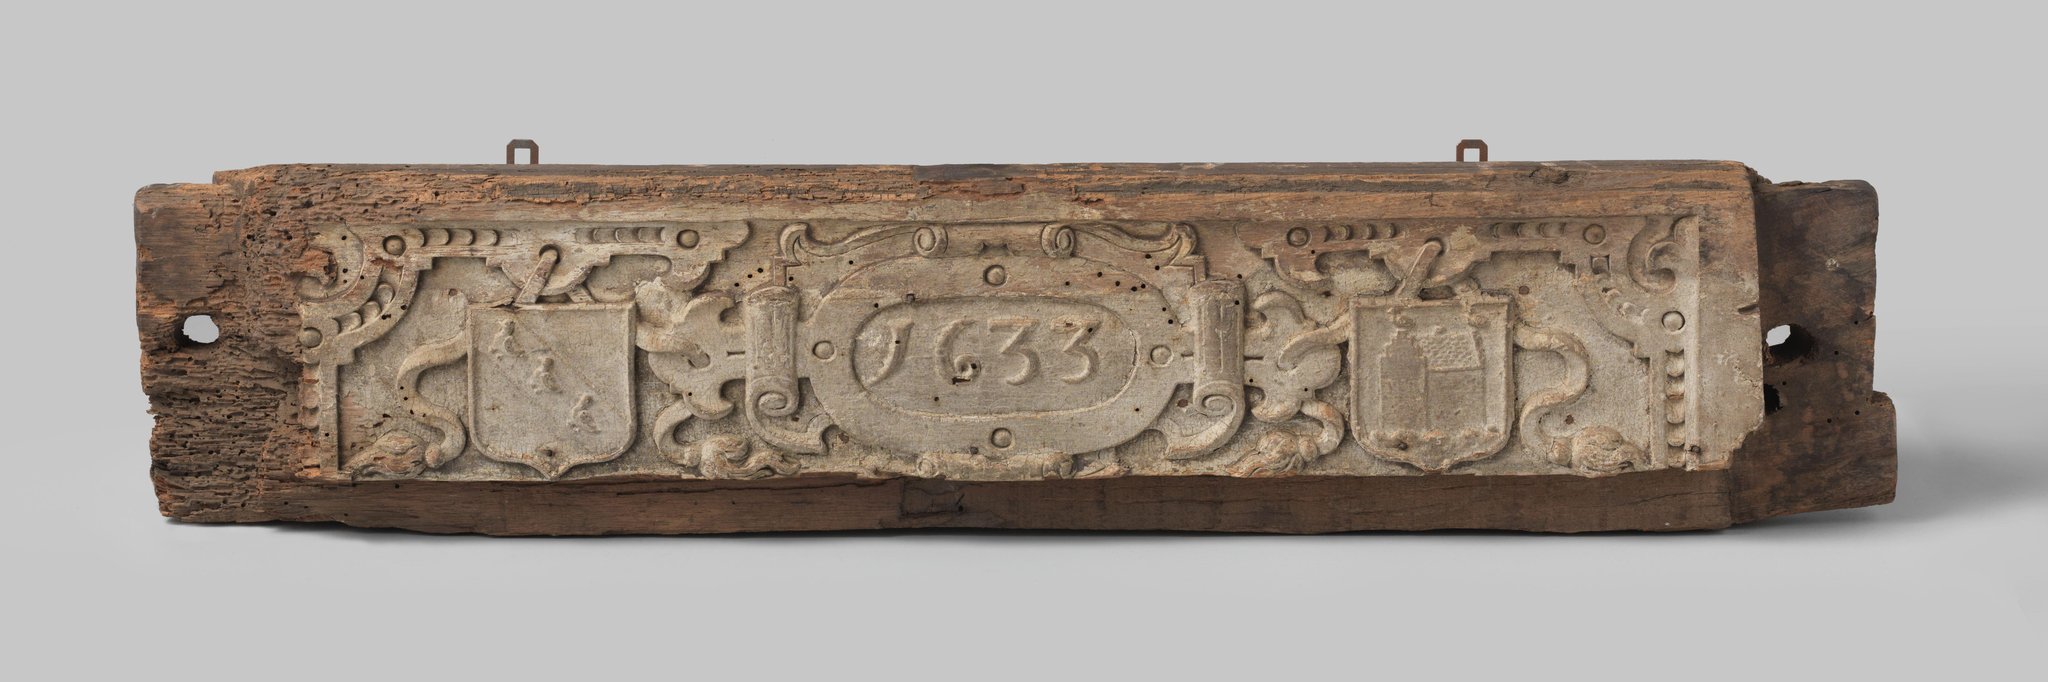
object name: deurkalf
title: Interieuronderdeel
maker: Anonymous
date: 1600-1650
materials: wood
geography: netherlands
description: Deurkalf met in een cartouche het jaartal 1633. Het snijwerk bestaat uit rolwerk. De cartouche wordt geflankeerd door twee wapenschilden die met een lint lopend door geschulpt bandwerk, met de cartouche zijn verbonden. Het linker schild vertoont een diagonaal lopende balk met drie eendjes; het rechter schild een huis met met voor- en achtergevel, bekroond door een eend. Eikenhout .